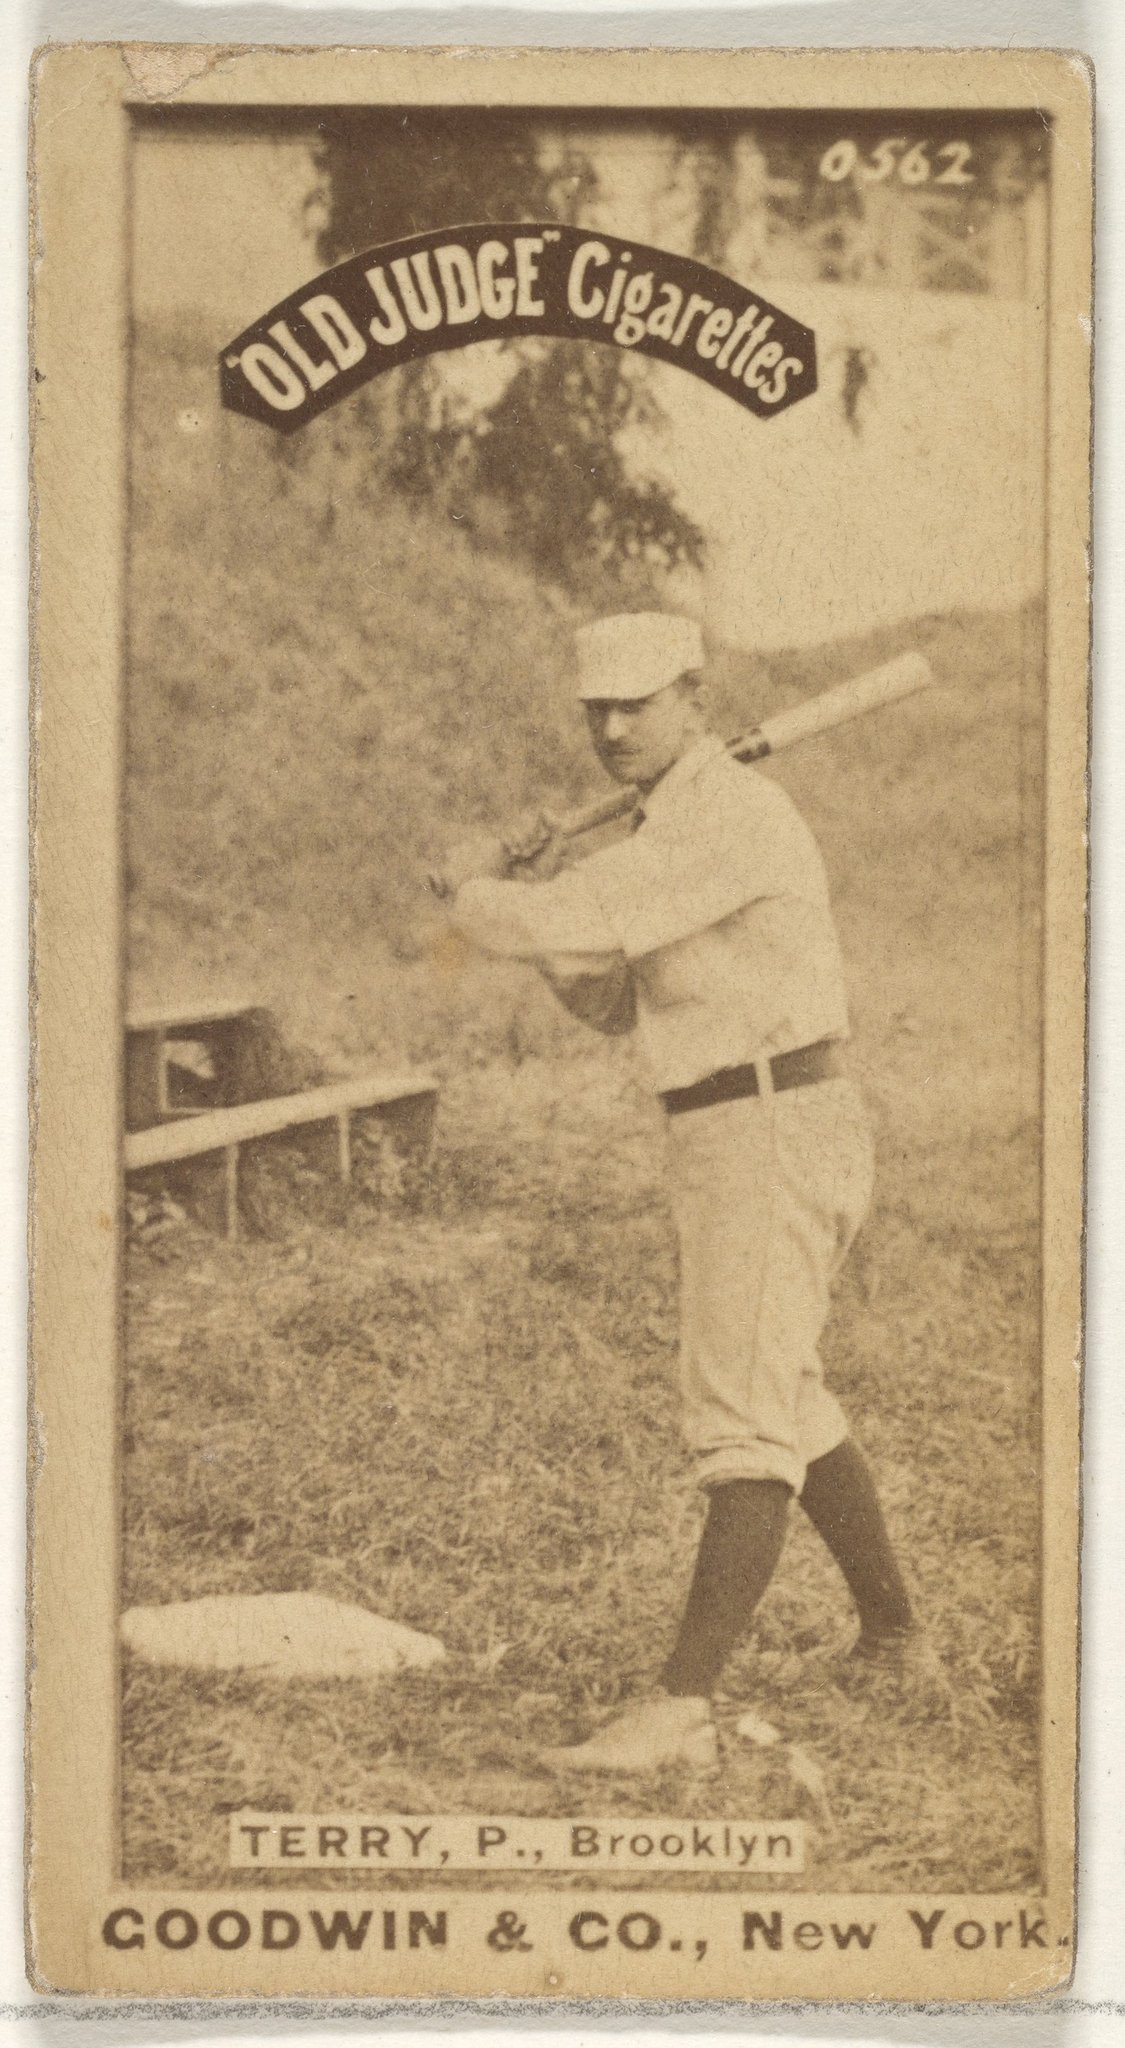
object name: baseball card, photograph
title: Terry, Pitcher, Brooklyn, from the Old Judge series (N172) for Old Judge Cigarettes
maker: goodwin & company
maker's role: publisher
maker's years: 1850-1950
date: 1887-1890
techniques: albumen silver print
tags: men,portraits,baseball,athletes